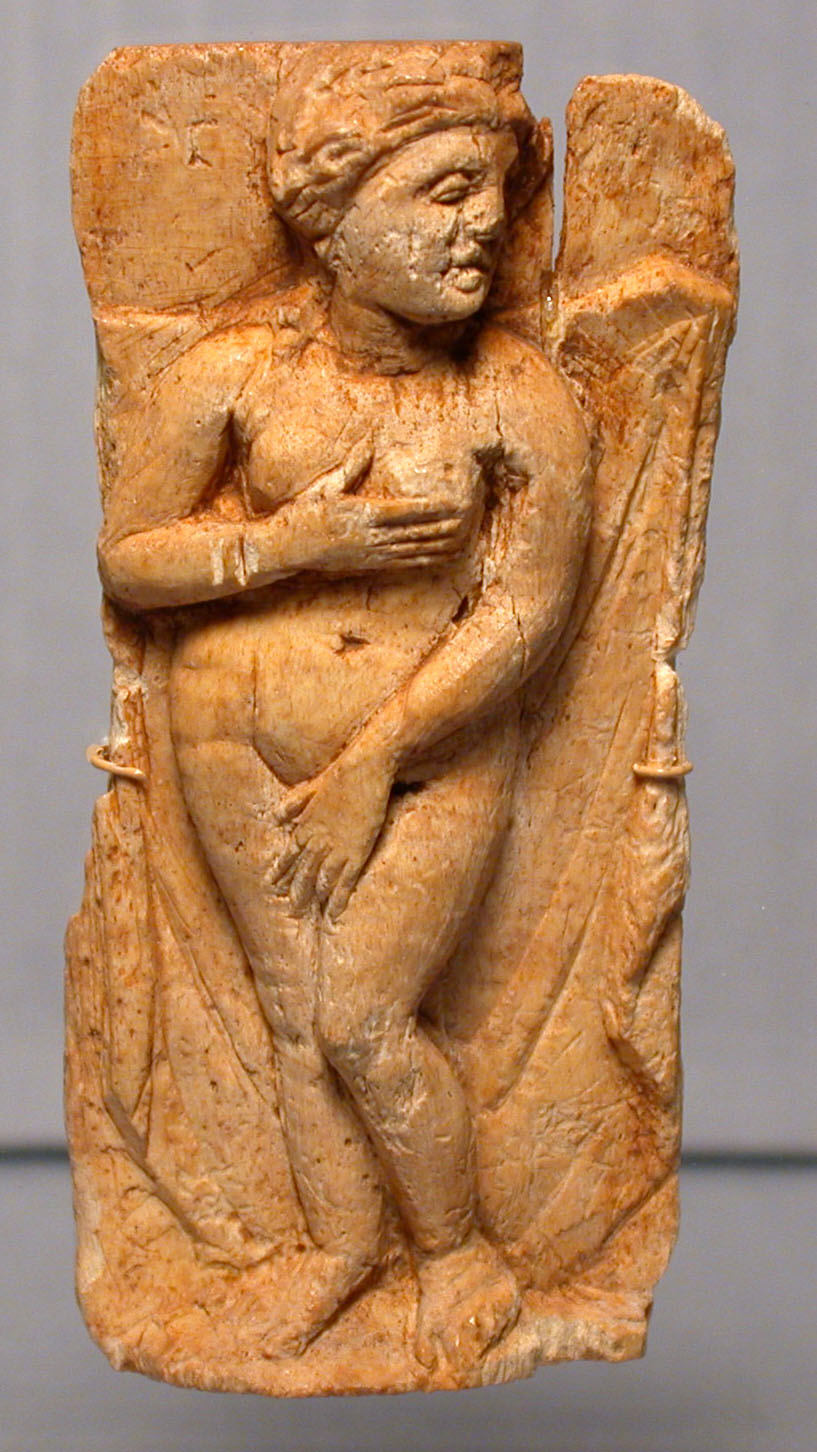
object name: plaque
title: Panel of Venus, “Pudica Type”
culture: byzantine or roman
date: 301-600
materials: bone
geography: egypt